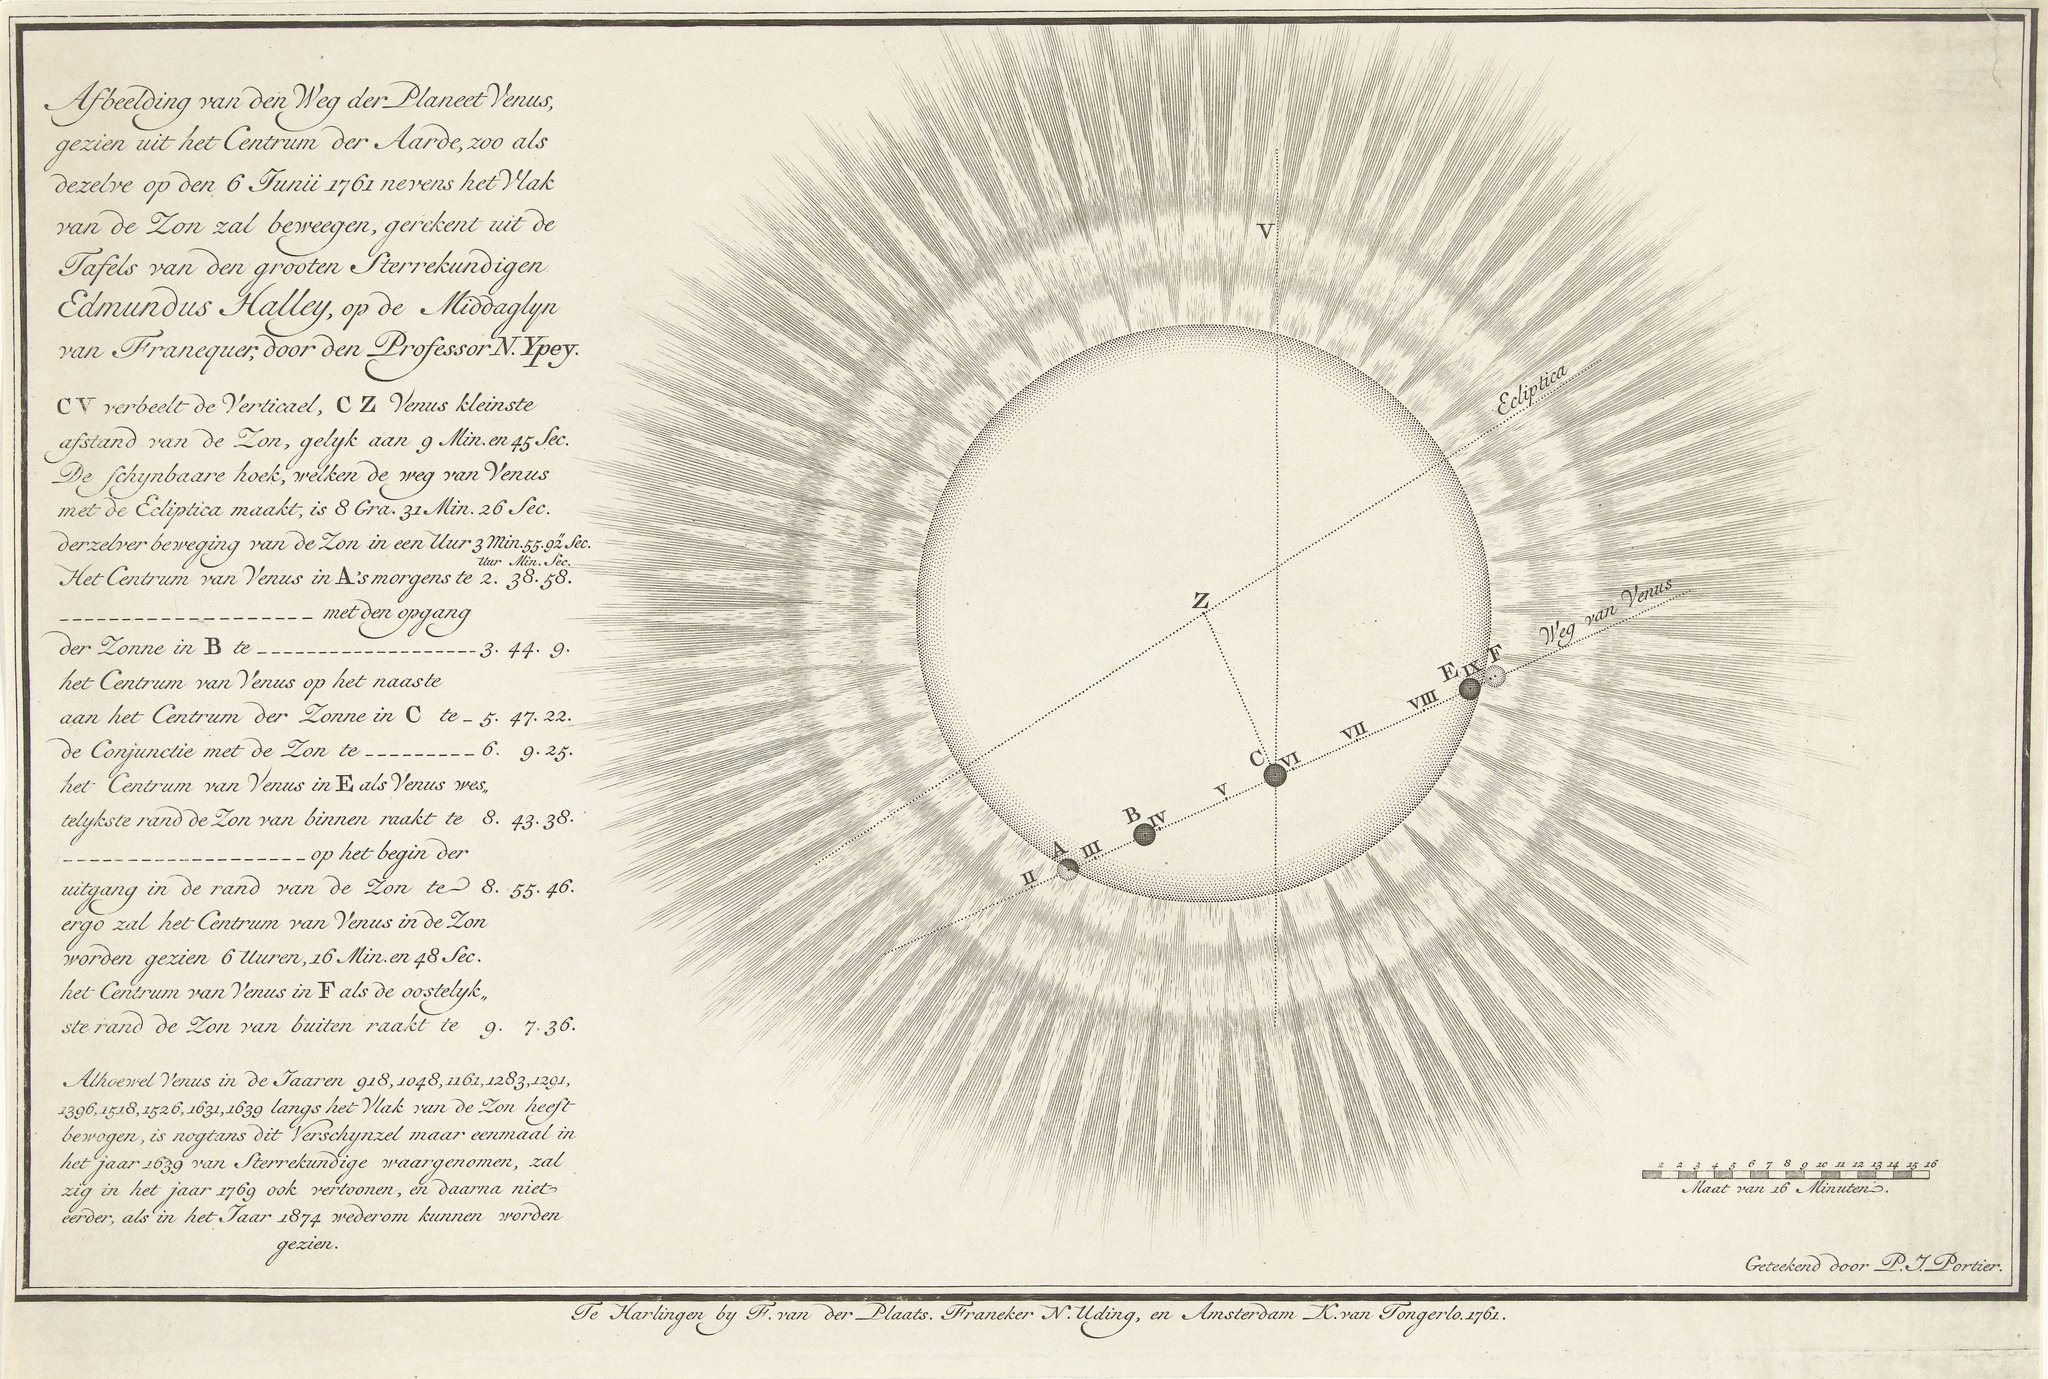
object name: print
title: Baan van Venus voor de zon, 6 juni 1761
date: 1761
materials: paper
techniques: engraving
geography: amsterdam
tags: sun as celestial body, venus (planet)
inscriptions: collector's mark: Lugt 2228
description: Astronomische voorstelling van de baan die de planeet Venus zal volgen als deze op de morgen van 6 juni 1761 voor de zon passeert, berekend door professor Nicolaas Ypey volgens de tabellen van de sterrenkundige Halley. De Romeinse cijfers geven het uur van de dag aan.